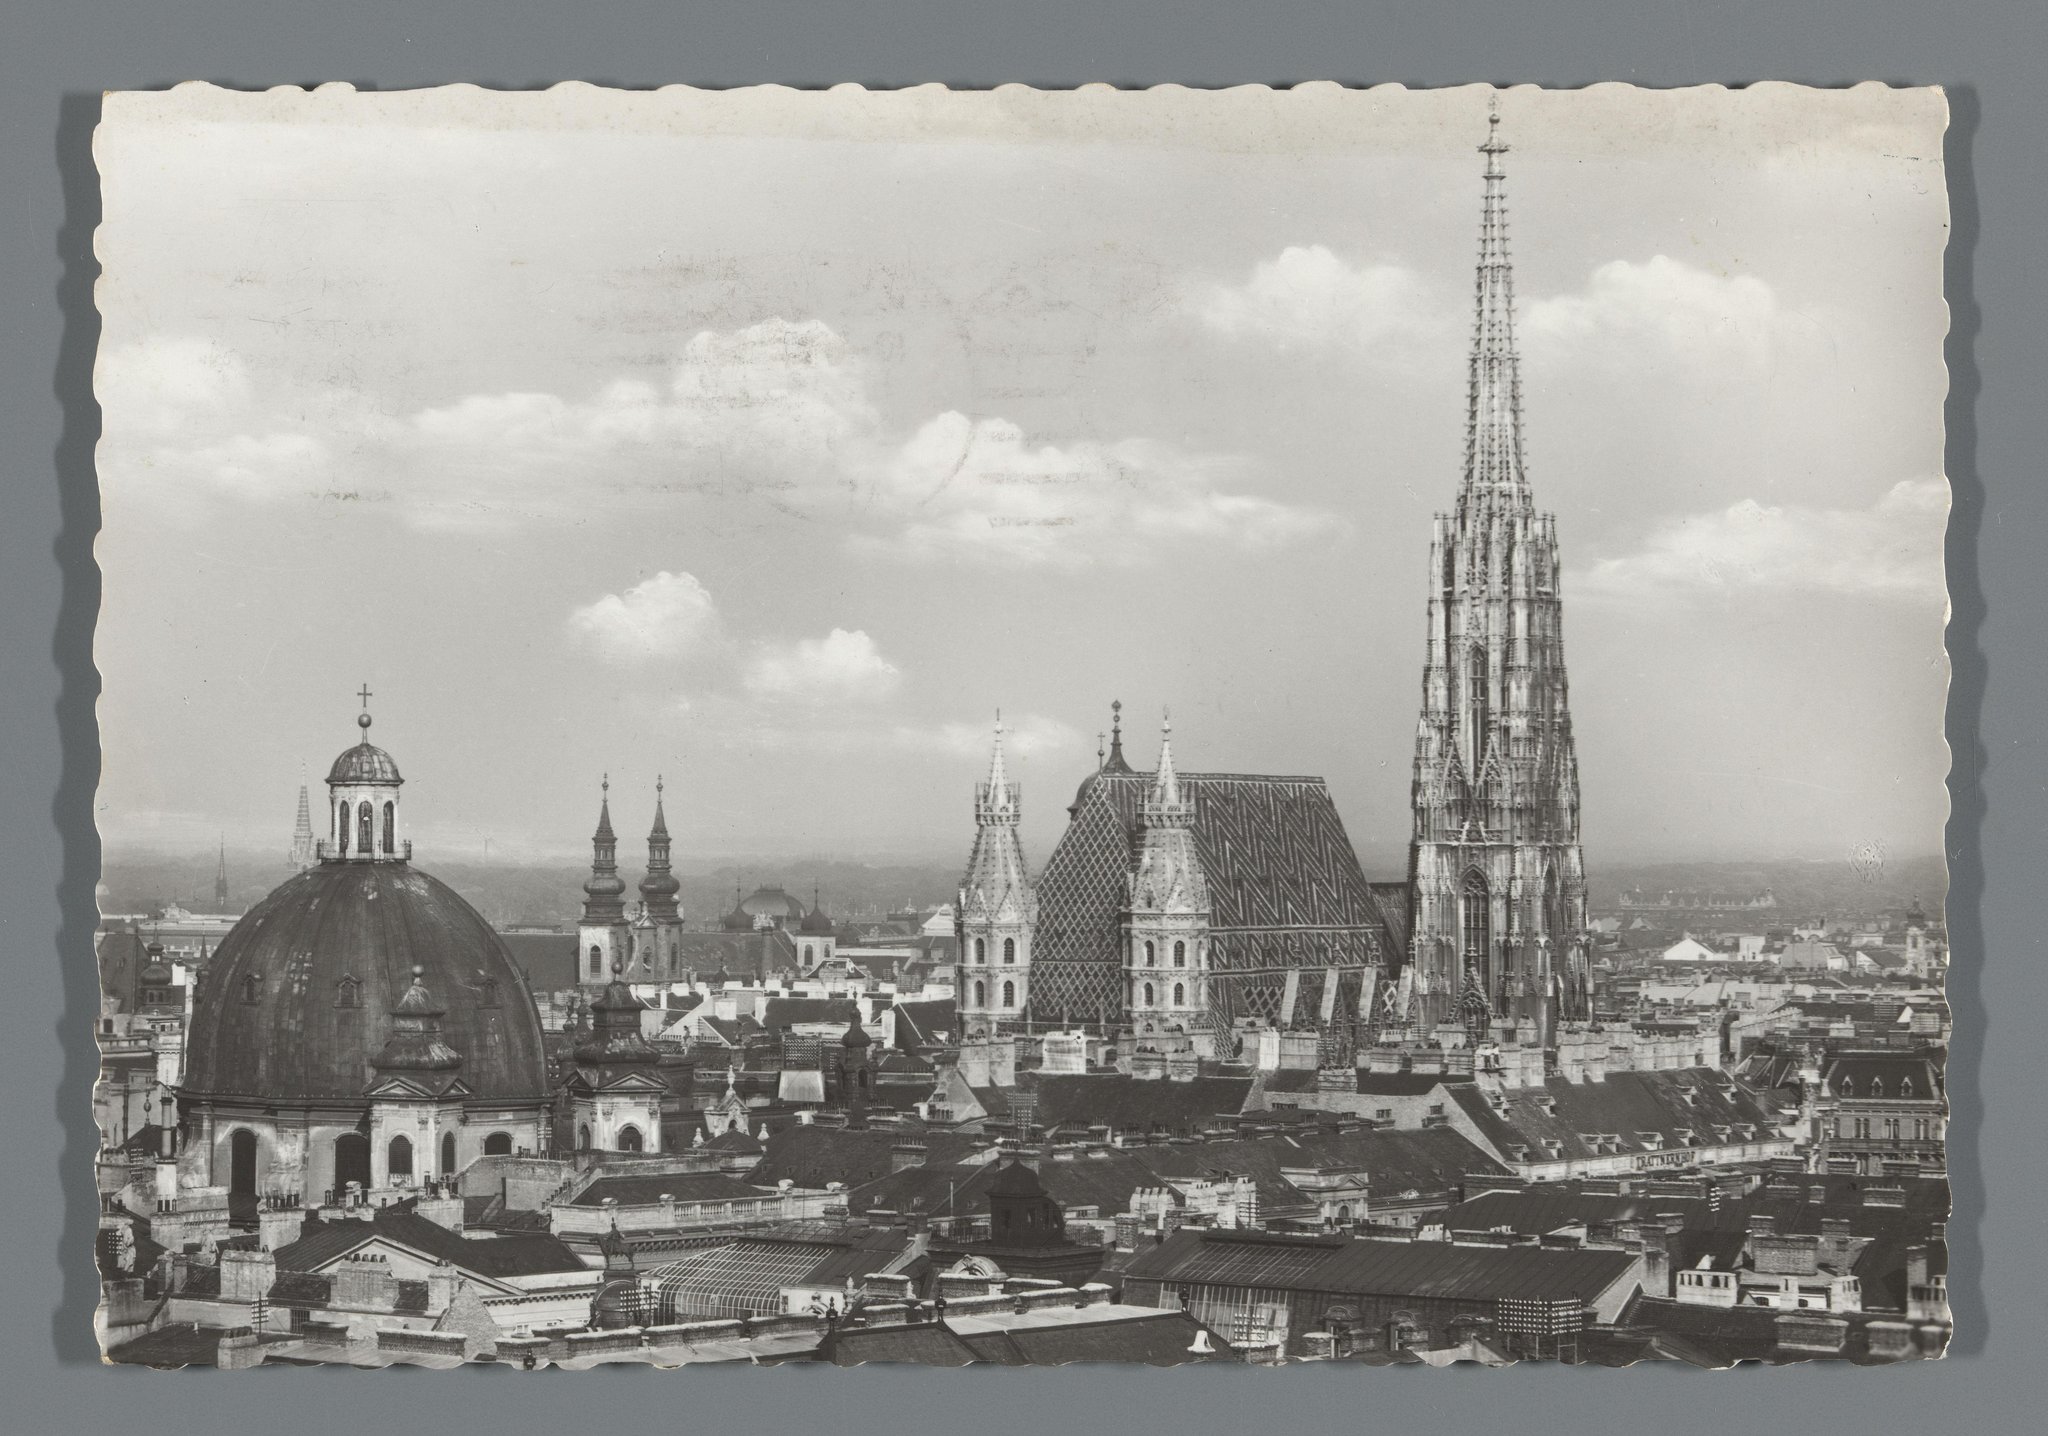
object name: postcard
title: Vienne, Panorama with Stephen's Cathedral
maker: Anonymous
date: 1920-1950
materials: photographic support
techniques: gelatin silver print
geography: vienna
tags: vienna